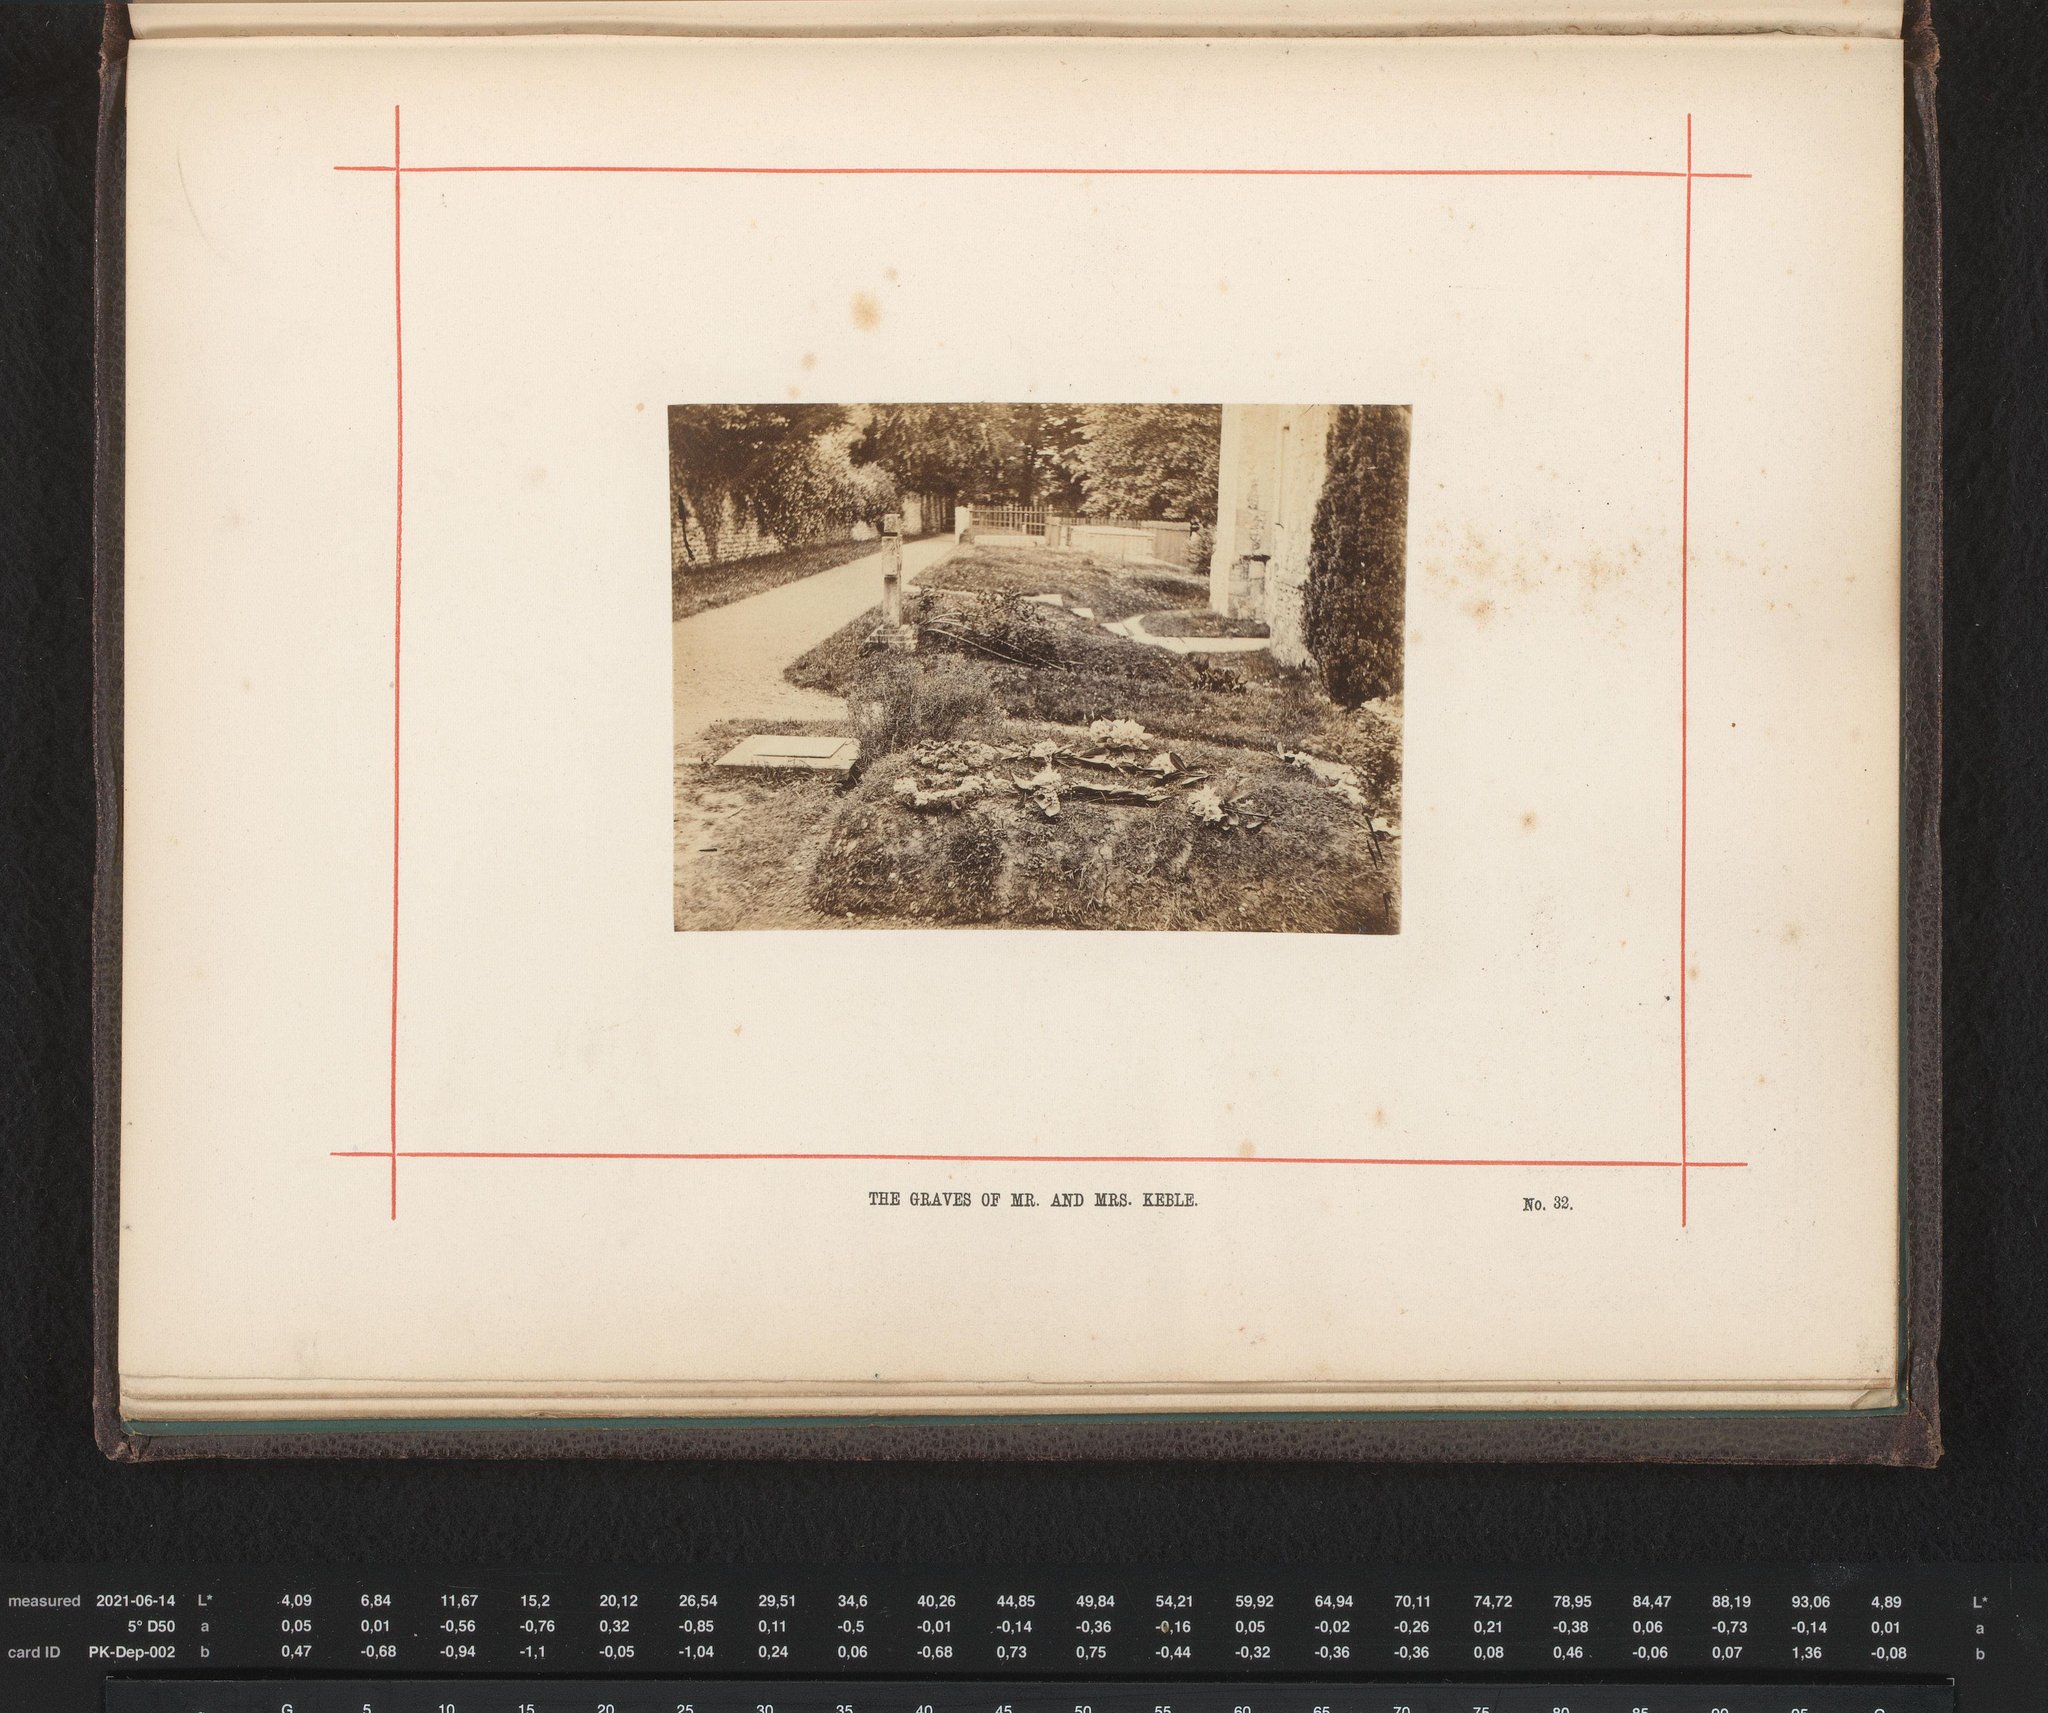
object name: photograph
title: Graf van John Keble en zijn vrouw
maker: william savage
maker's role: fotograaf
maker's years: 1817-1887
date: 1861-1866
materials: paper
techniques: albumen print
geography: hursley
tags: john keble, grave, tomb